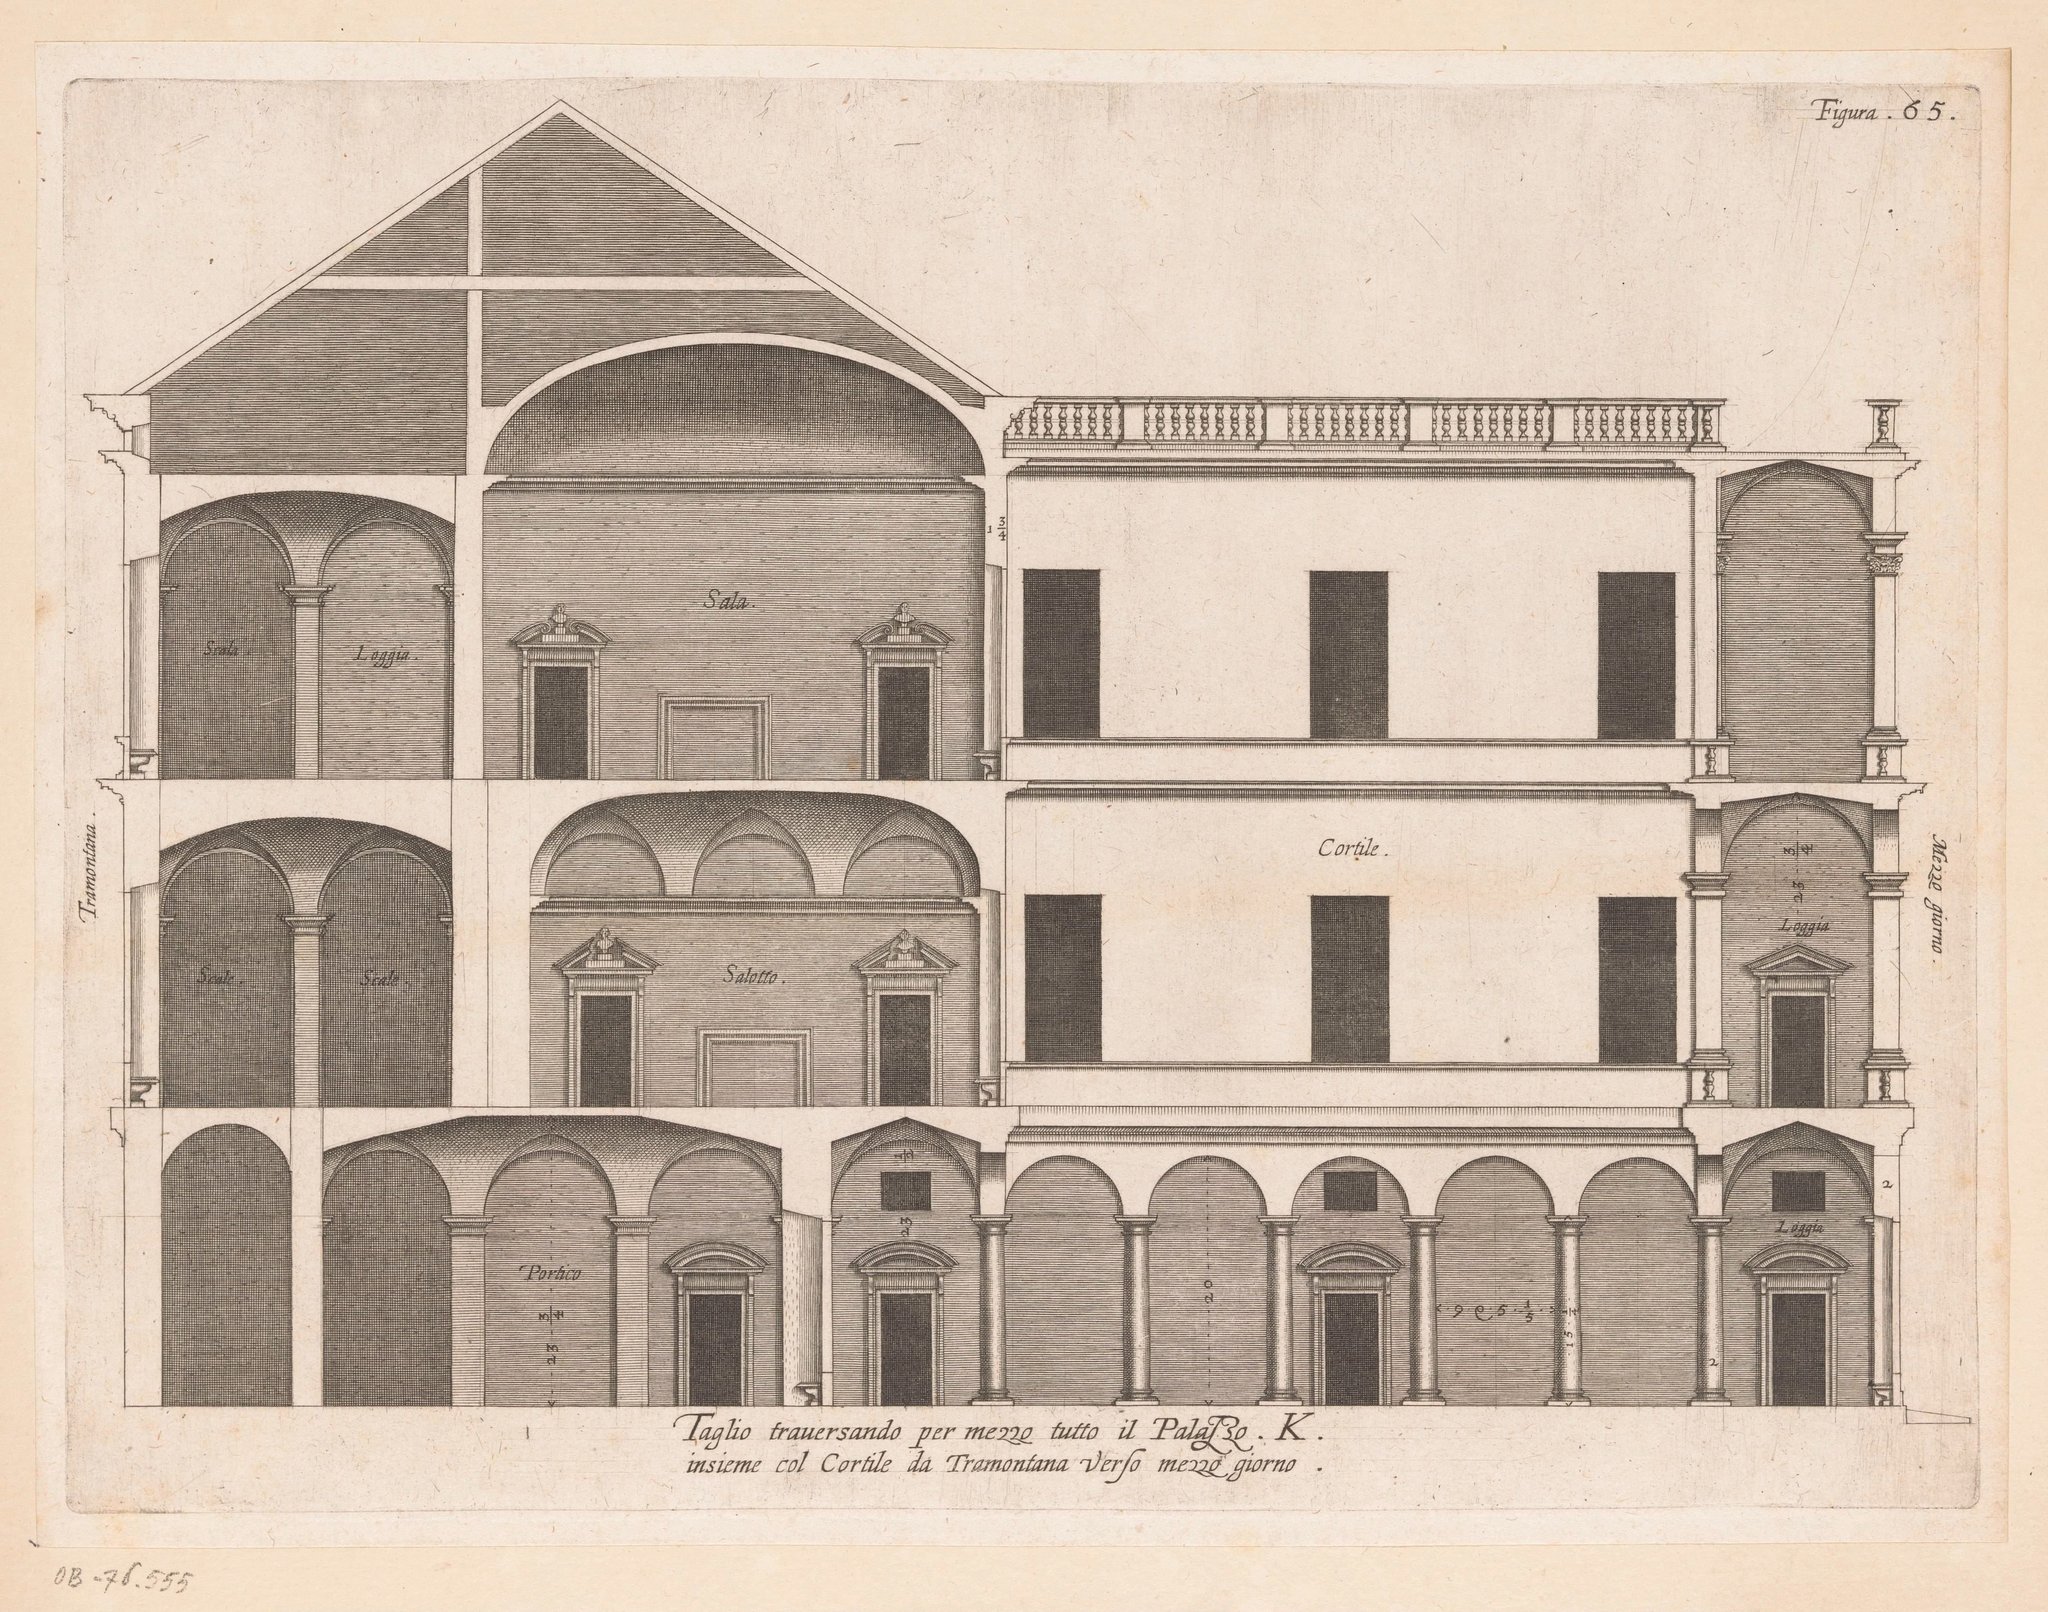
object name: print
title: Taglio traversando per mezzo tutto il Palazzo. K. insieme col cortile da tramontana verso mezzo giorno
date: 1622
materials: paper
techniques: engraving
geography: antwerp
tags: hôtel, i.e. small palace in city - aa - civic architecture: inside, section ~ architectural design or model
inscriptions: collector's mark: Lugt 240